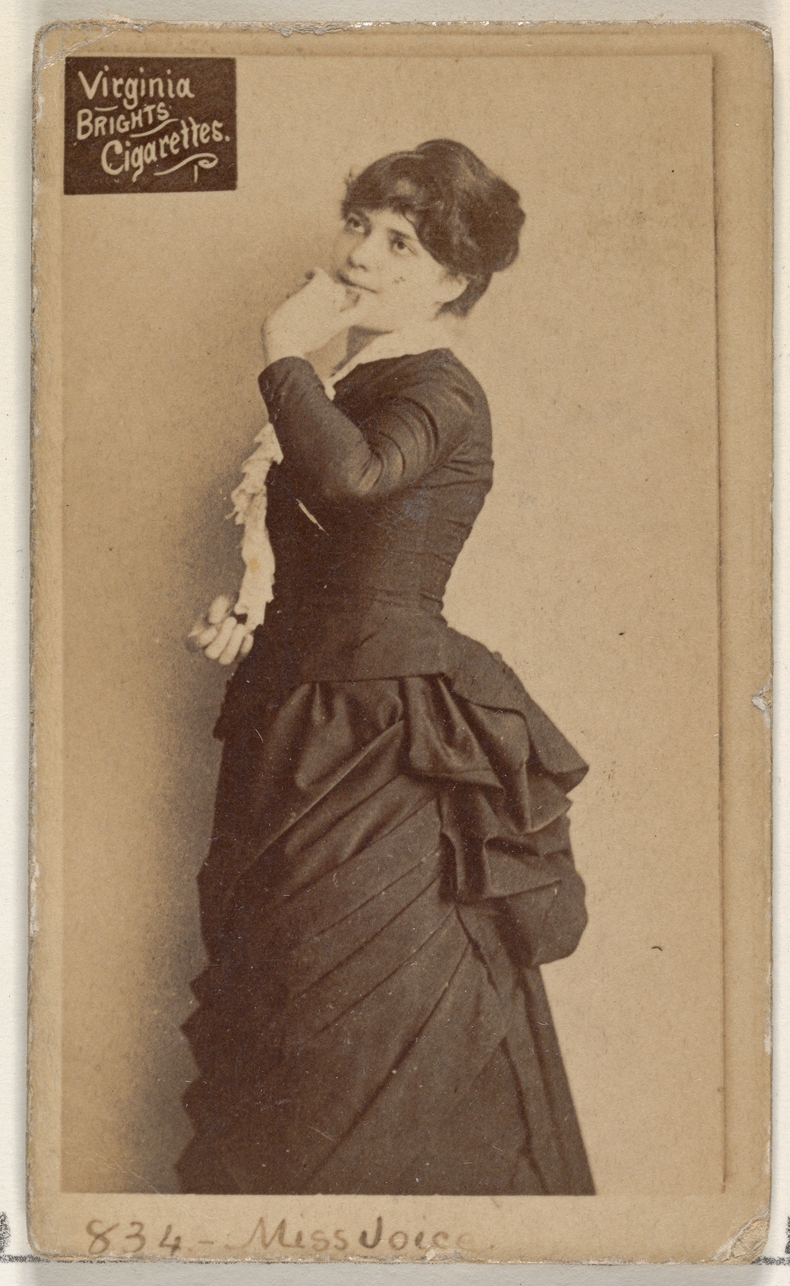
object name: photograph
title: Card 834, Miss Joice, from the Actors and Actresses series (N45, Type 2) for Virginia Brights Cigarettes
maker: allen & ginter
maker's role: publisher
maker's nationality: american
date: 1888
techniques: albumen silver print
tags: portraits,women,actresses